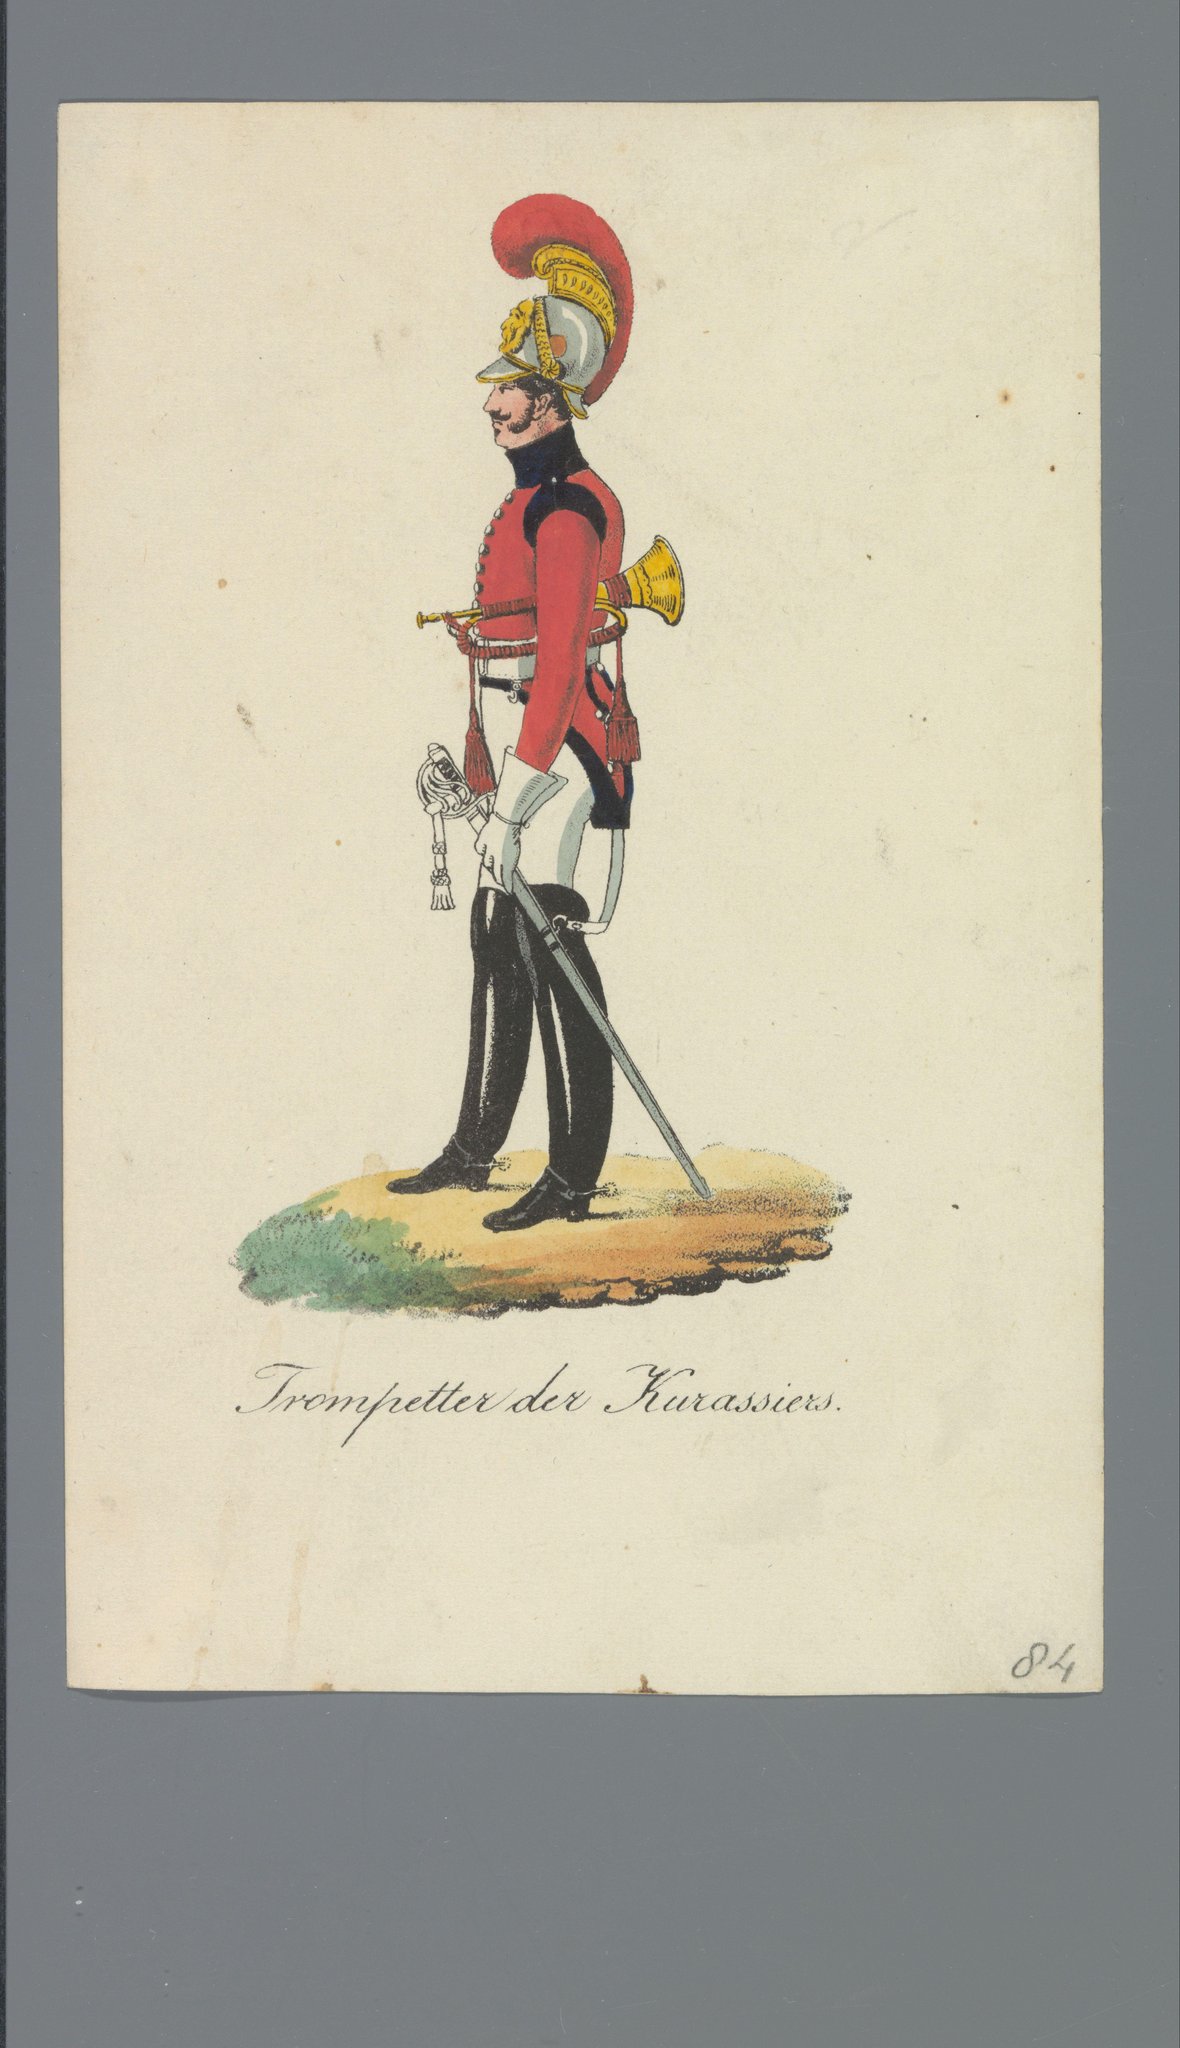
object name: costume print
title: Nederlandse militaire uniformen in de jaren 1830-1832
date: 1835-1850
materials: paper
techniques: hand coloring, lithograph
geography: netherlands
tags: (military) uniforms, clothes, costume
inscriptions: collector's mark: Lugt 2228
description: Een trompetter van de Kurassiers, te voet. Onderdeel van een serie van 157 losse bladen met Nederlandse militaire uniformen in de jaren 1830-1832.